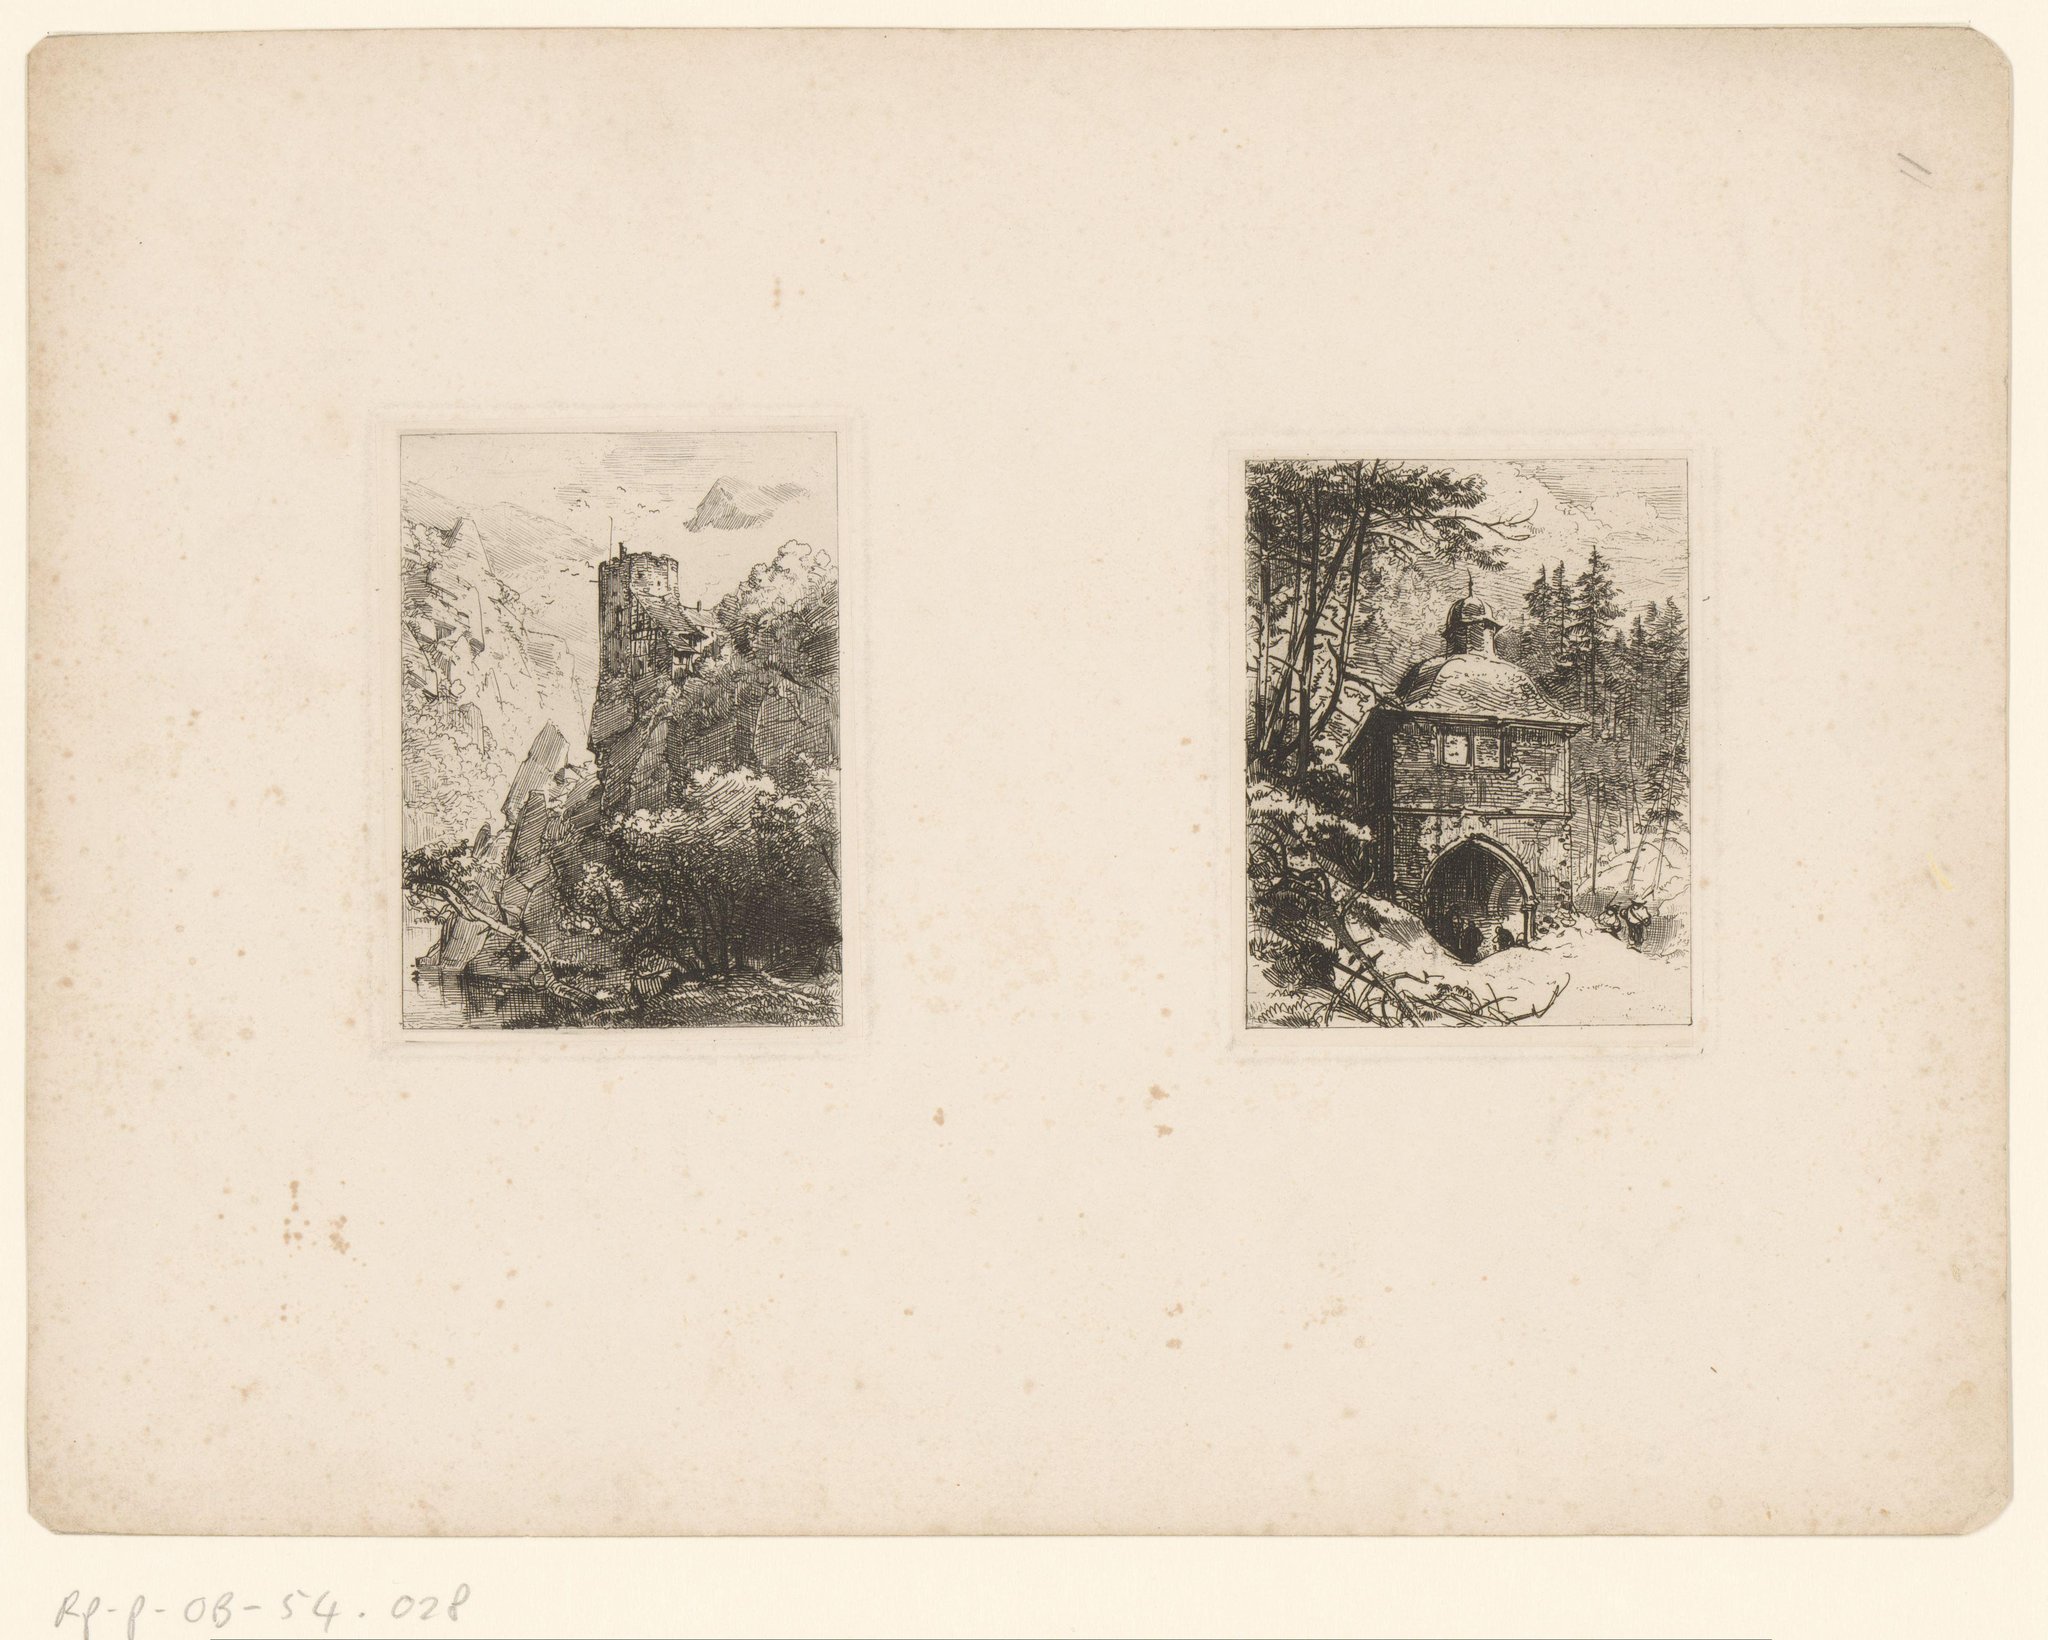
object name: print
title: Twee voorstellingen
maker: caspar johann nepomuk scheuren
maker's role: draughtsman, print maker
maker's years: 1810-1887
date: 1842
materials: paper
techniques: etching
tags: city-view, and landscape with man-made constructions, forest, wood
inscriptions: collector's mark: Lugt 2228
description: Prent onderdeel van een serie van twaalf bladen met etsen.